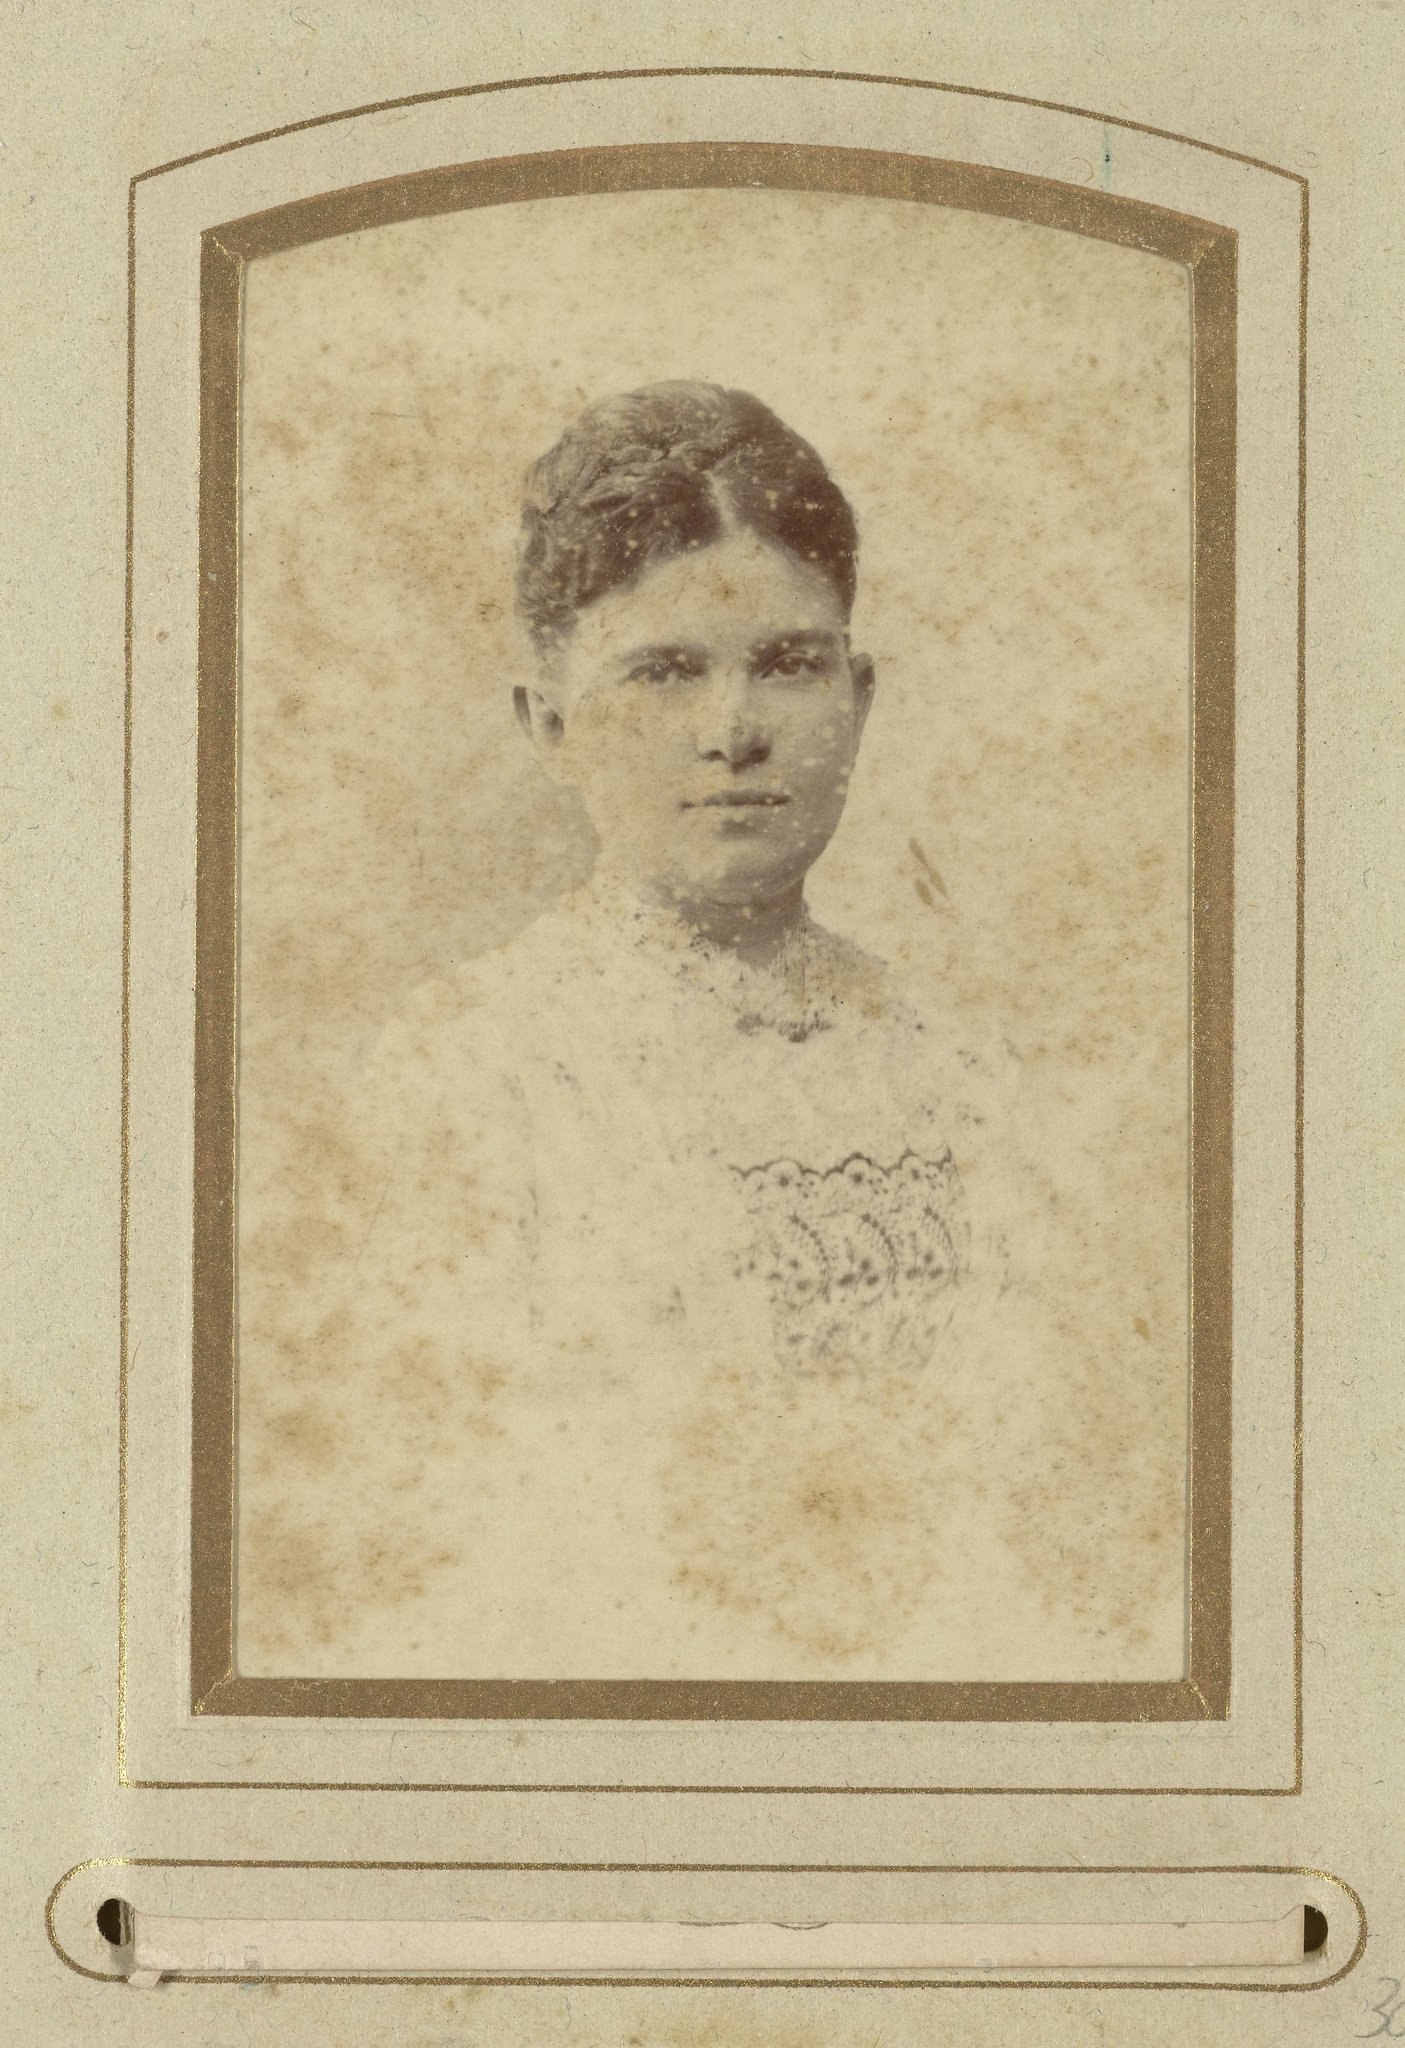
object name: photograph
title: Portret van Margo J.J. Kessler-de Lange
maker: richard kameke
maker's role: fotograaf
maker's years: 1847-1898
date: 1890-1910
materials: paper, photographic support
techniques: photography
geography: the hague